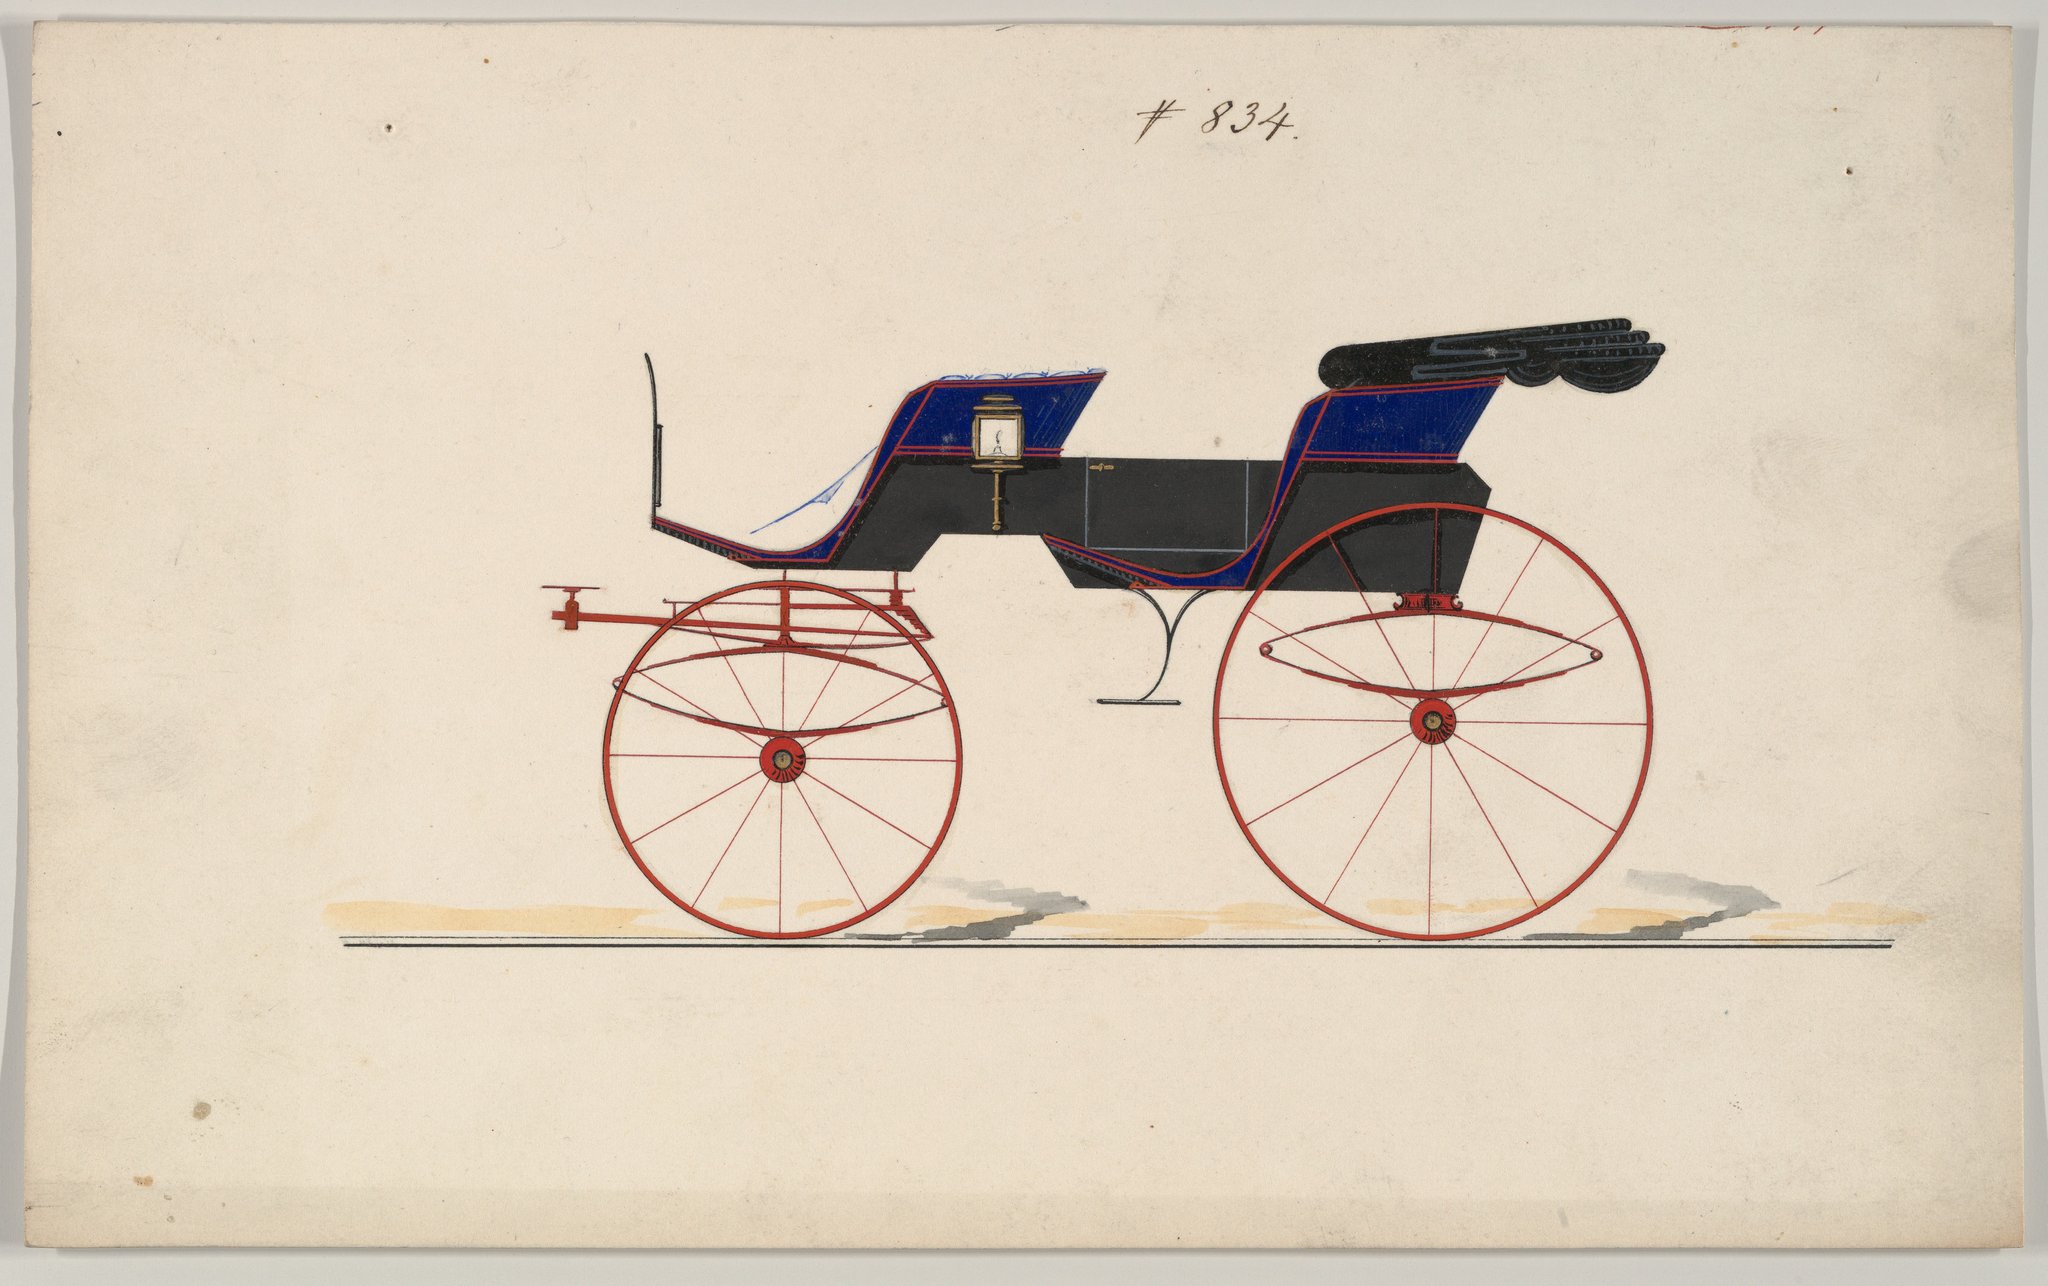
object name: drawing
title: Design for Phaeton, no. 834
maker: brewster & co.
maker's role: manufacturer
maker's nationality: american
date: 1850-1874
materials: gouache, ink, watercolor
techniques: pen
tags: carriages